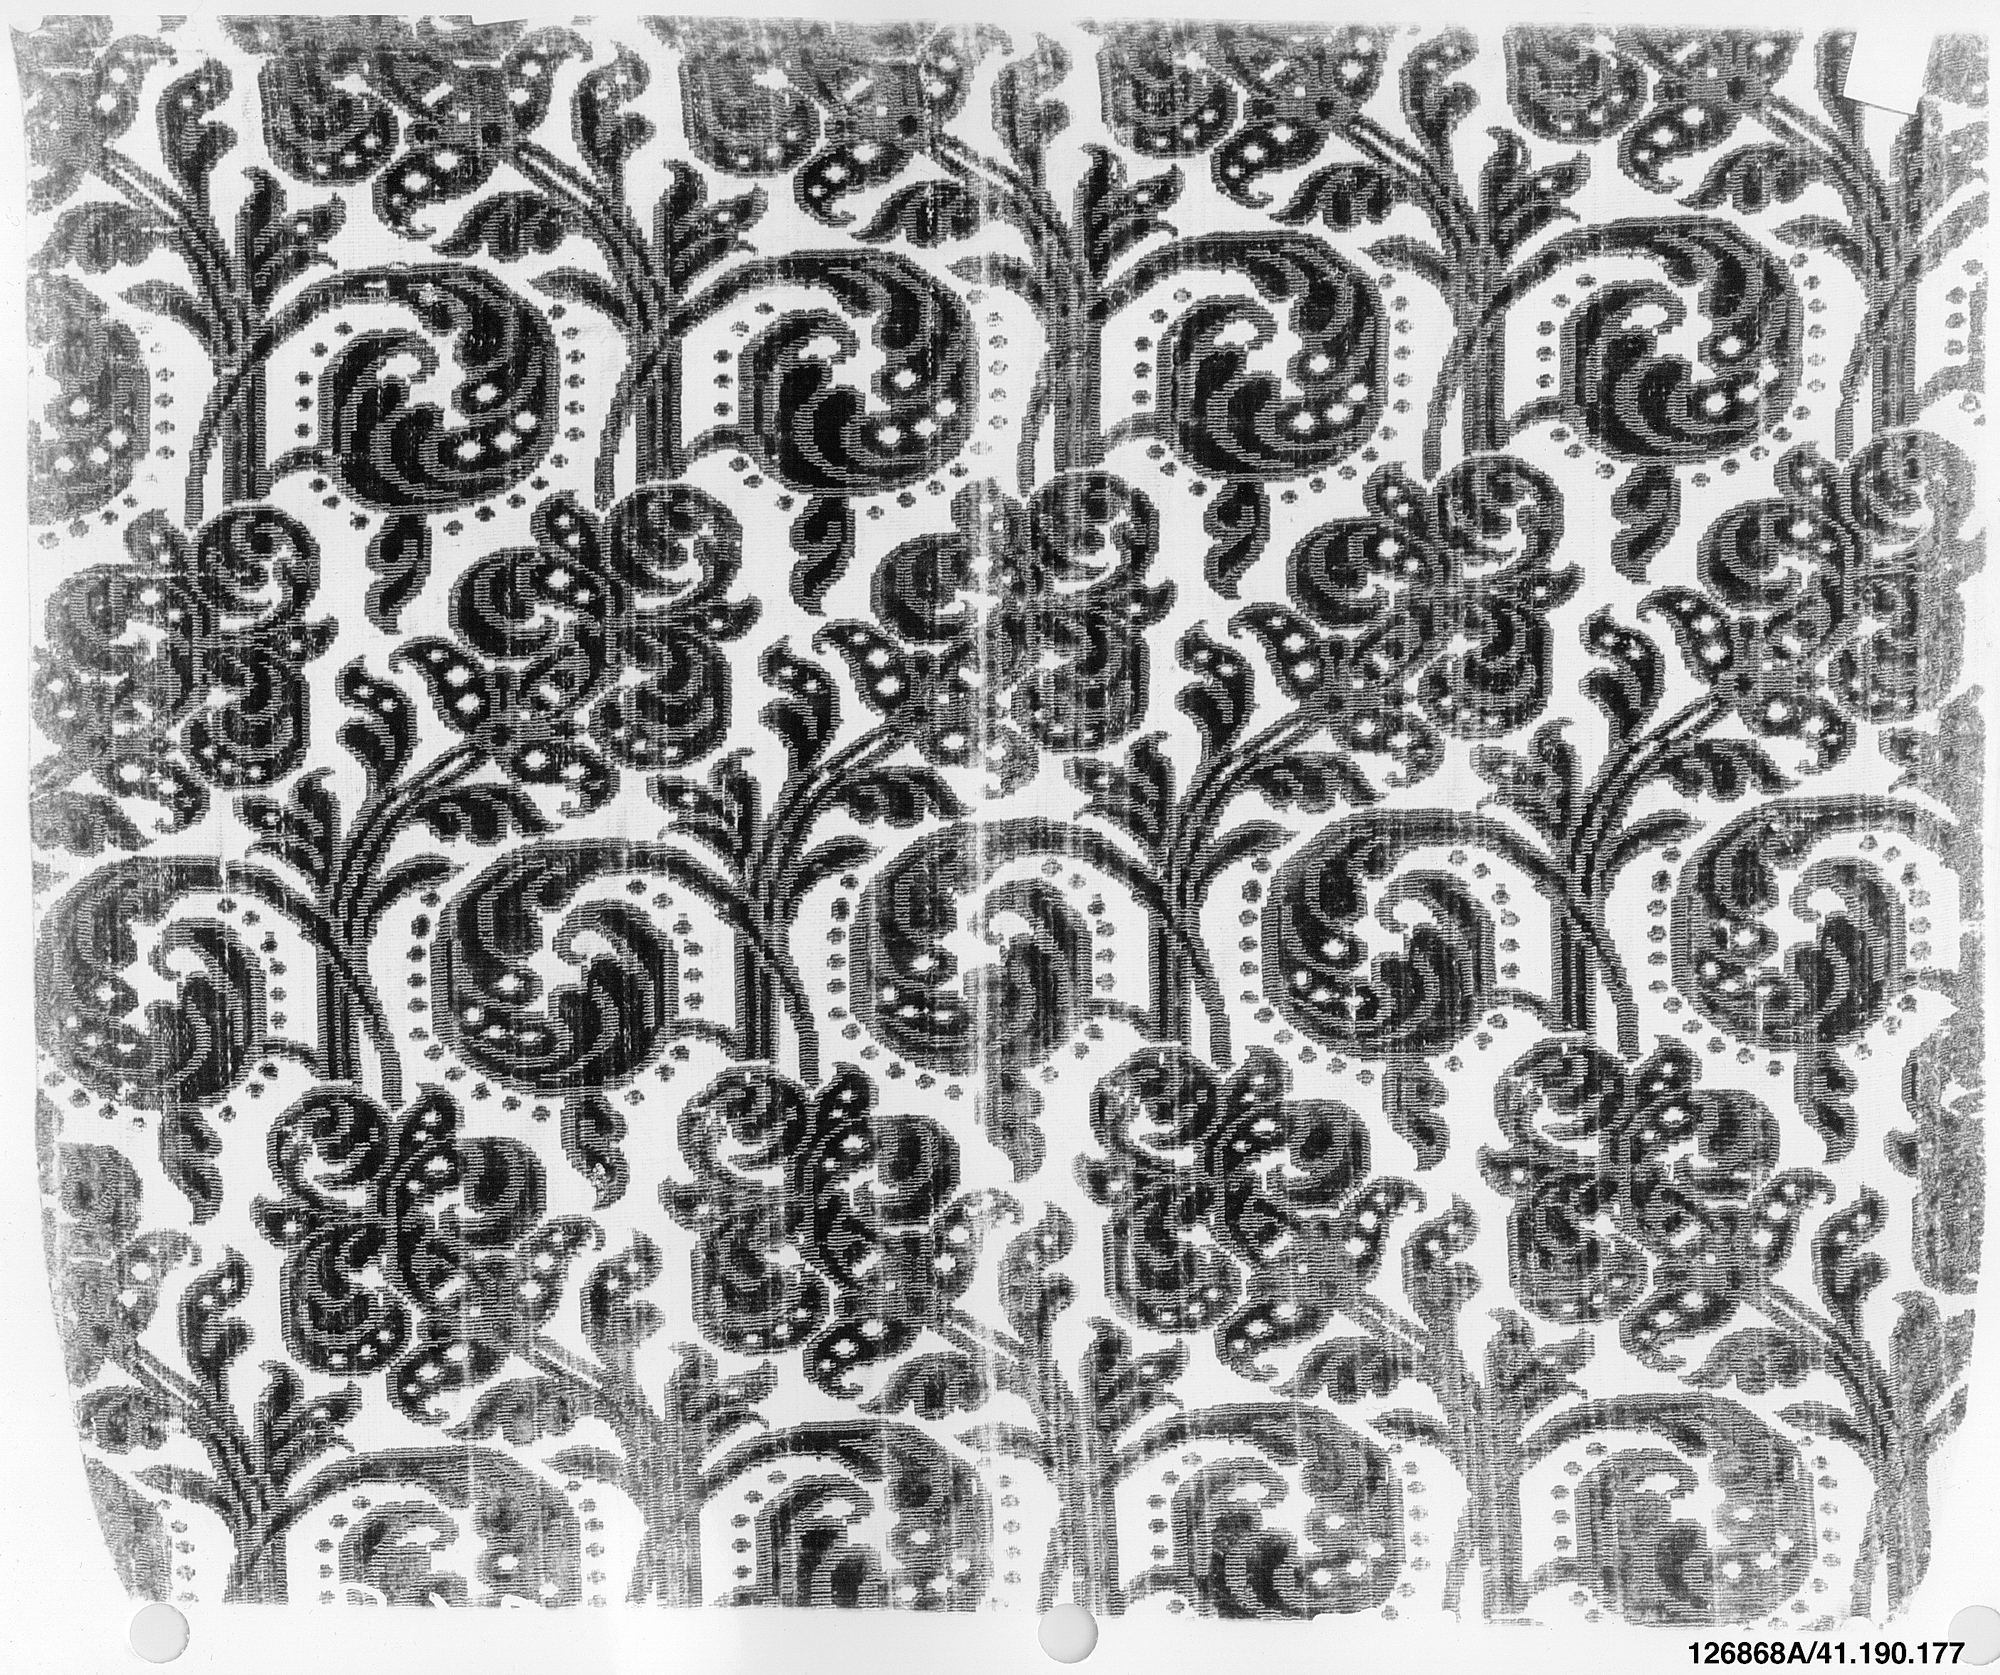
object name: piece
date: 1501-1600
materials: silk